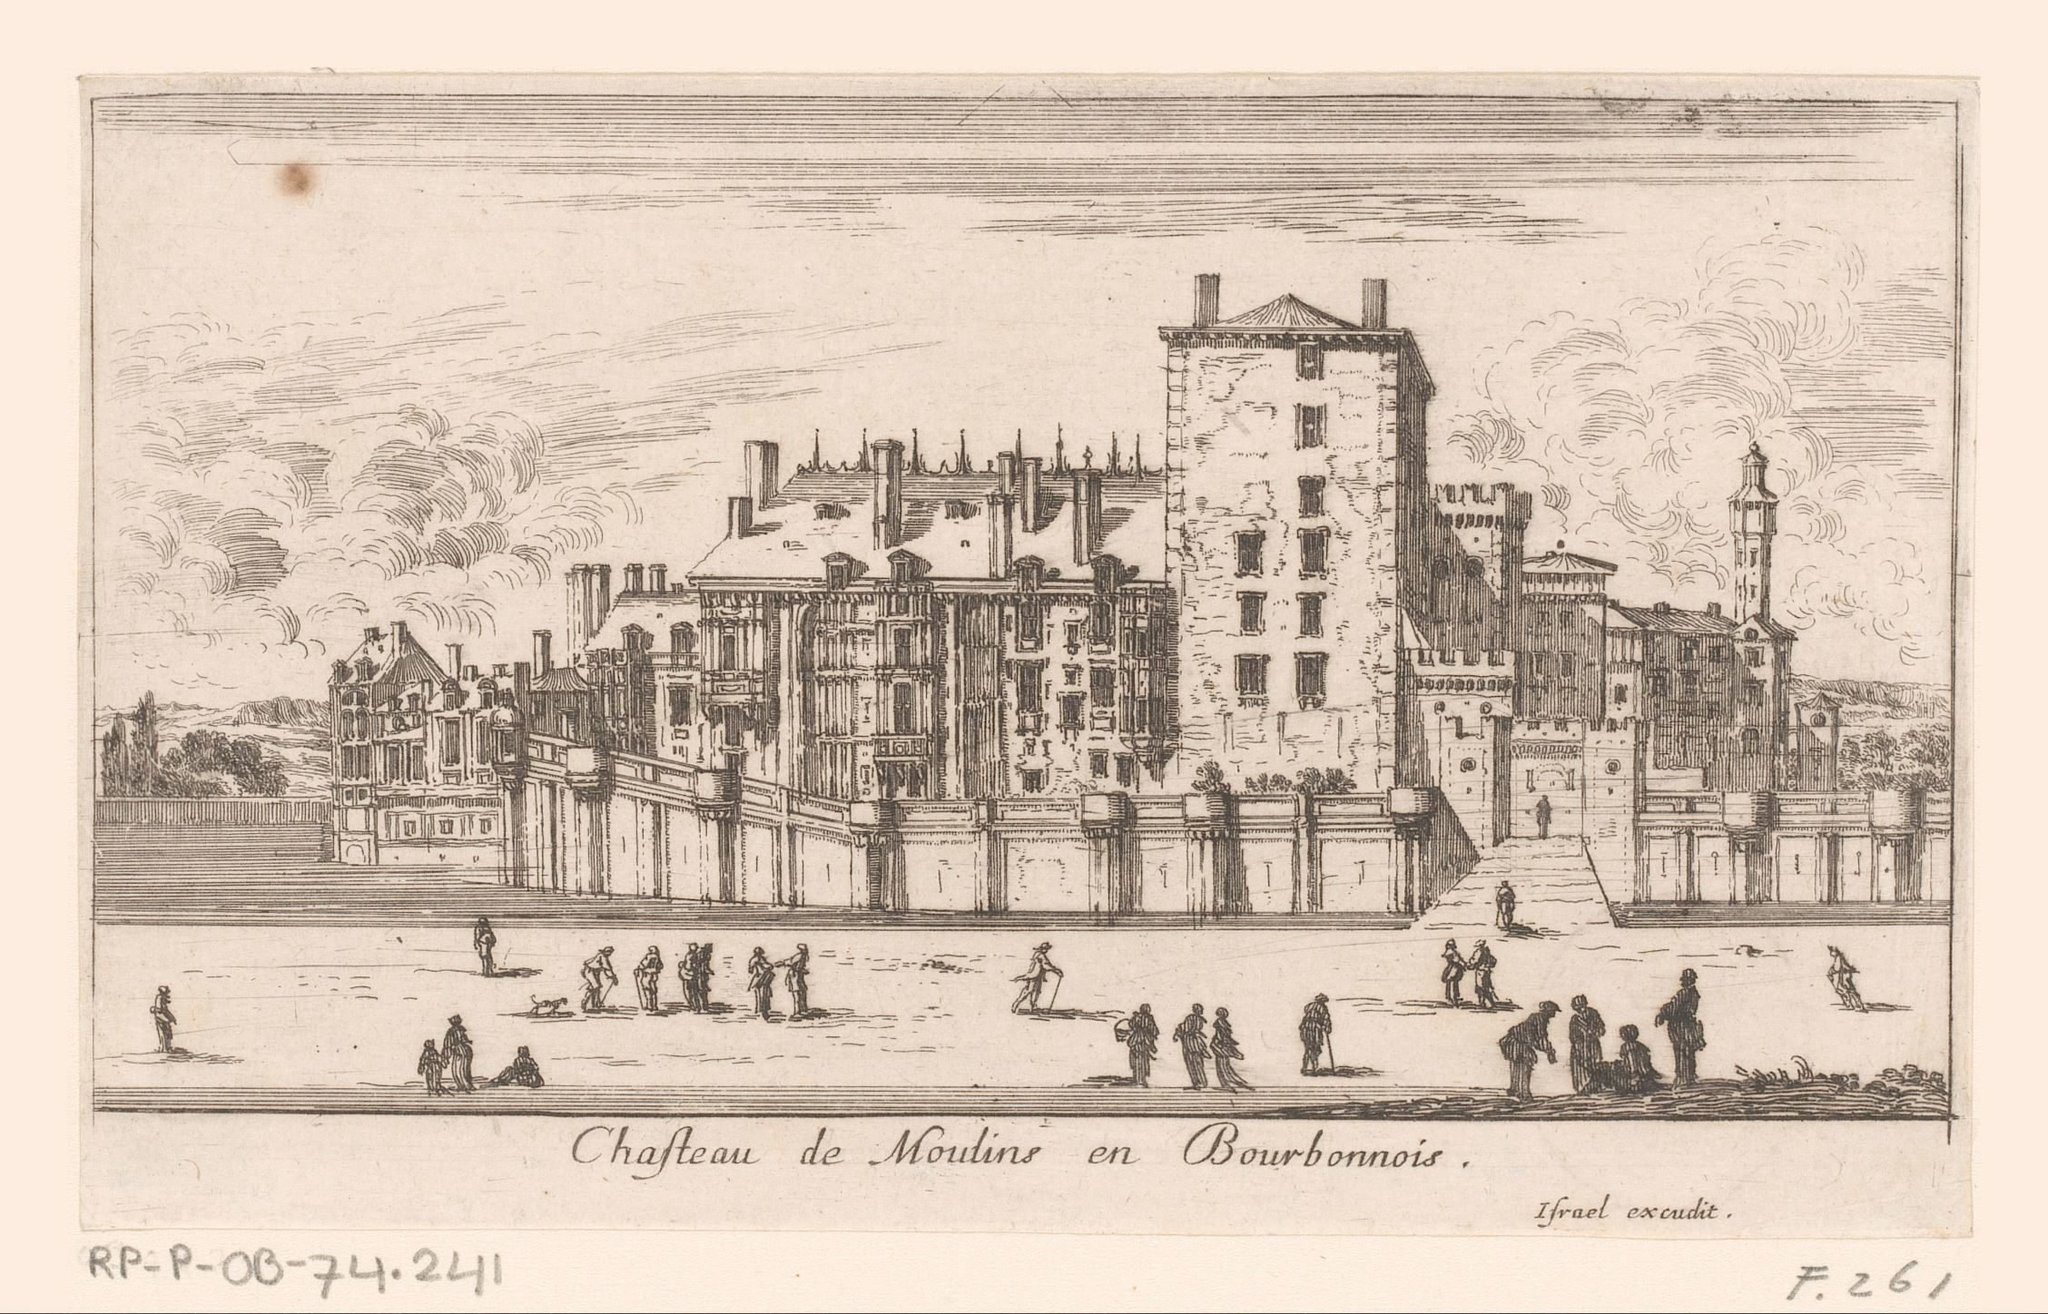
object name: print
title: Chasteau de Moulins en Bourbonnois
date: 1631-1691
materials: paper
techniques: engraving, etching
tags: landscape with tower or castle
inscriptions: collector's mark: Lugt 240